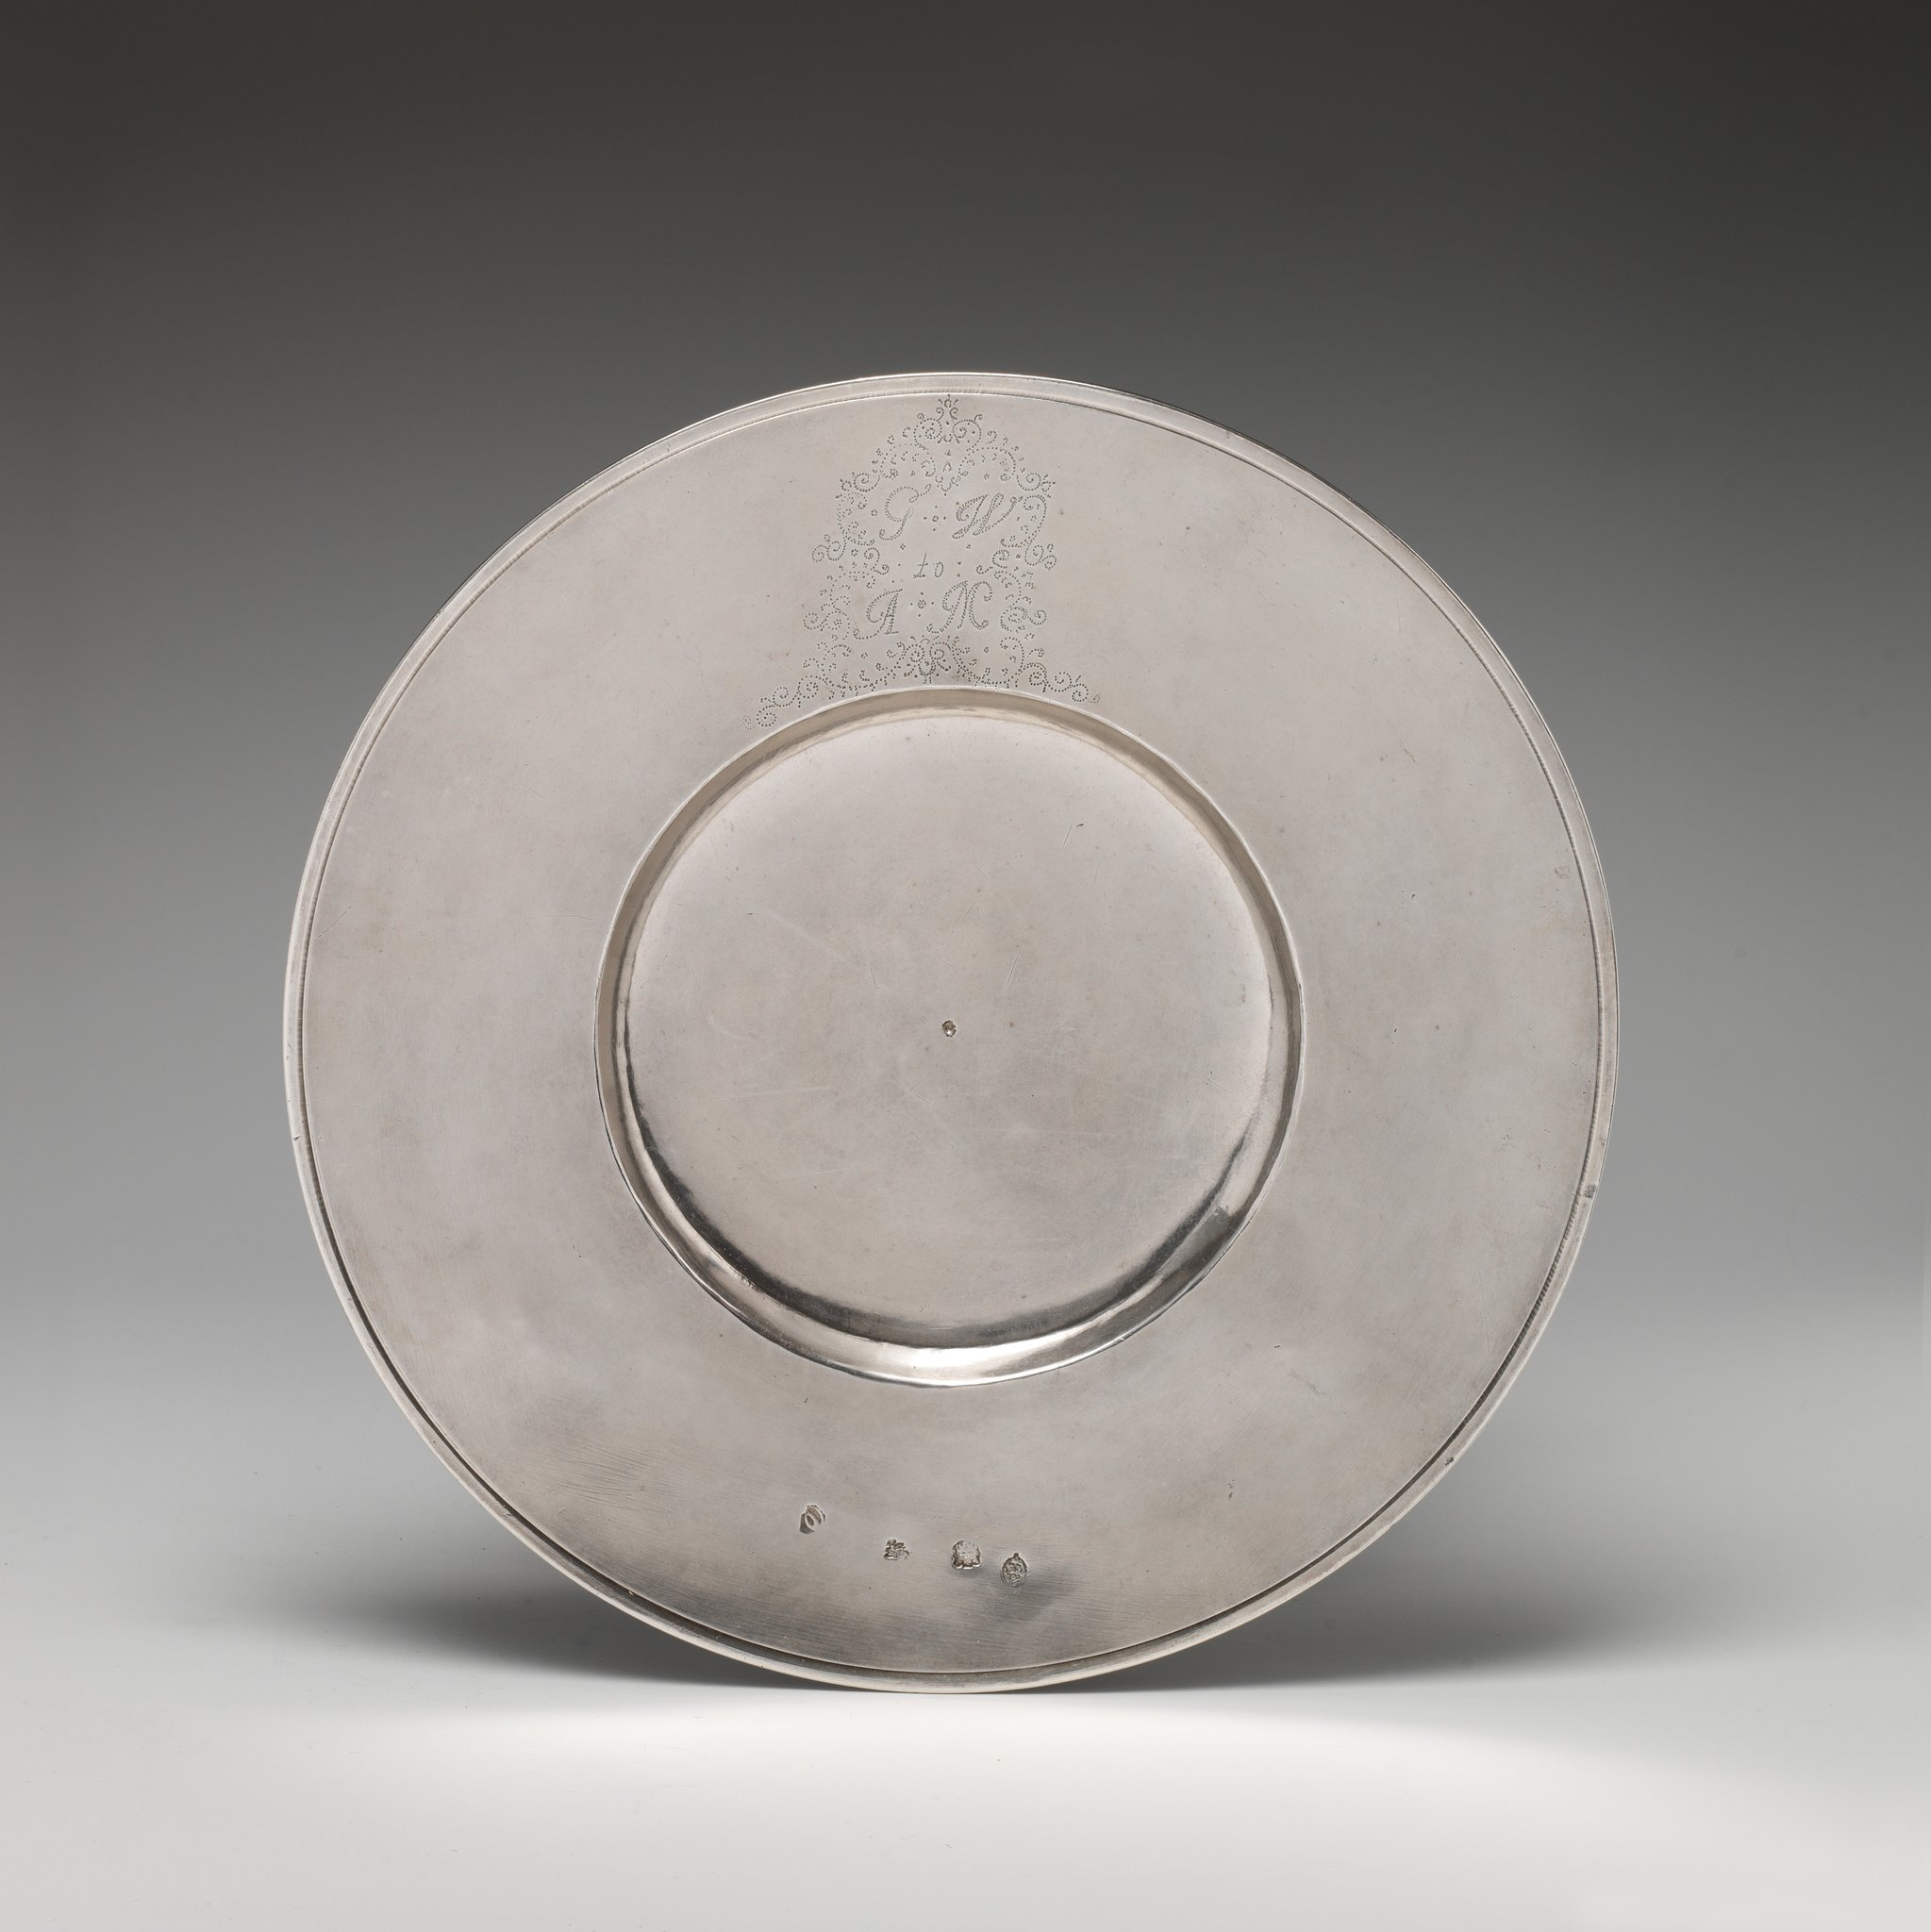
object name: plate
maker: t. g., london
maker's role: maker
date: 1655-1656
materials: silver